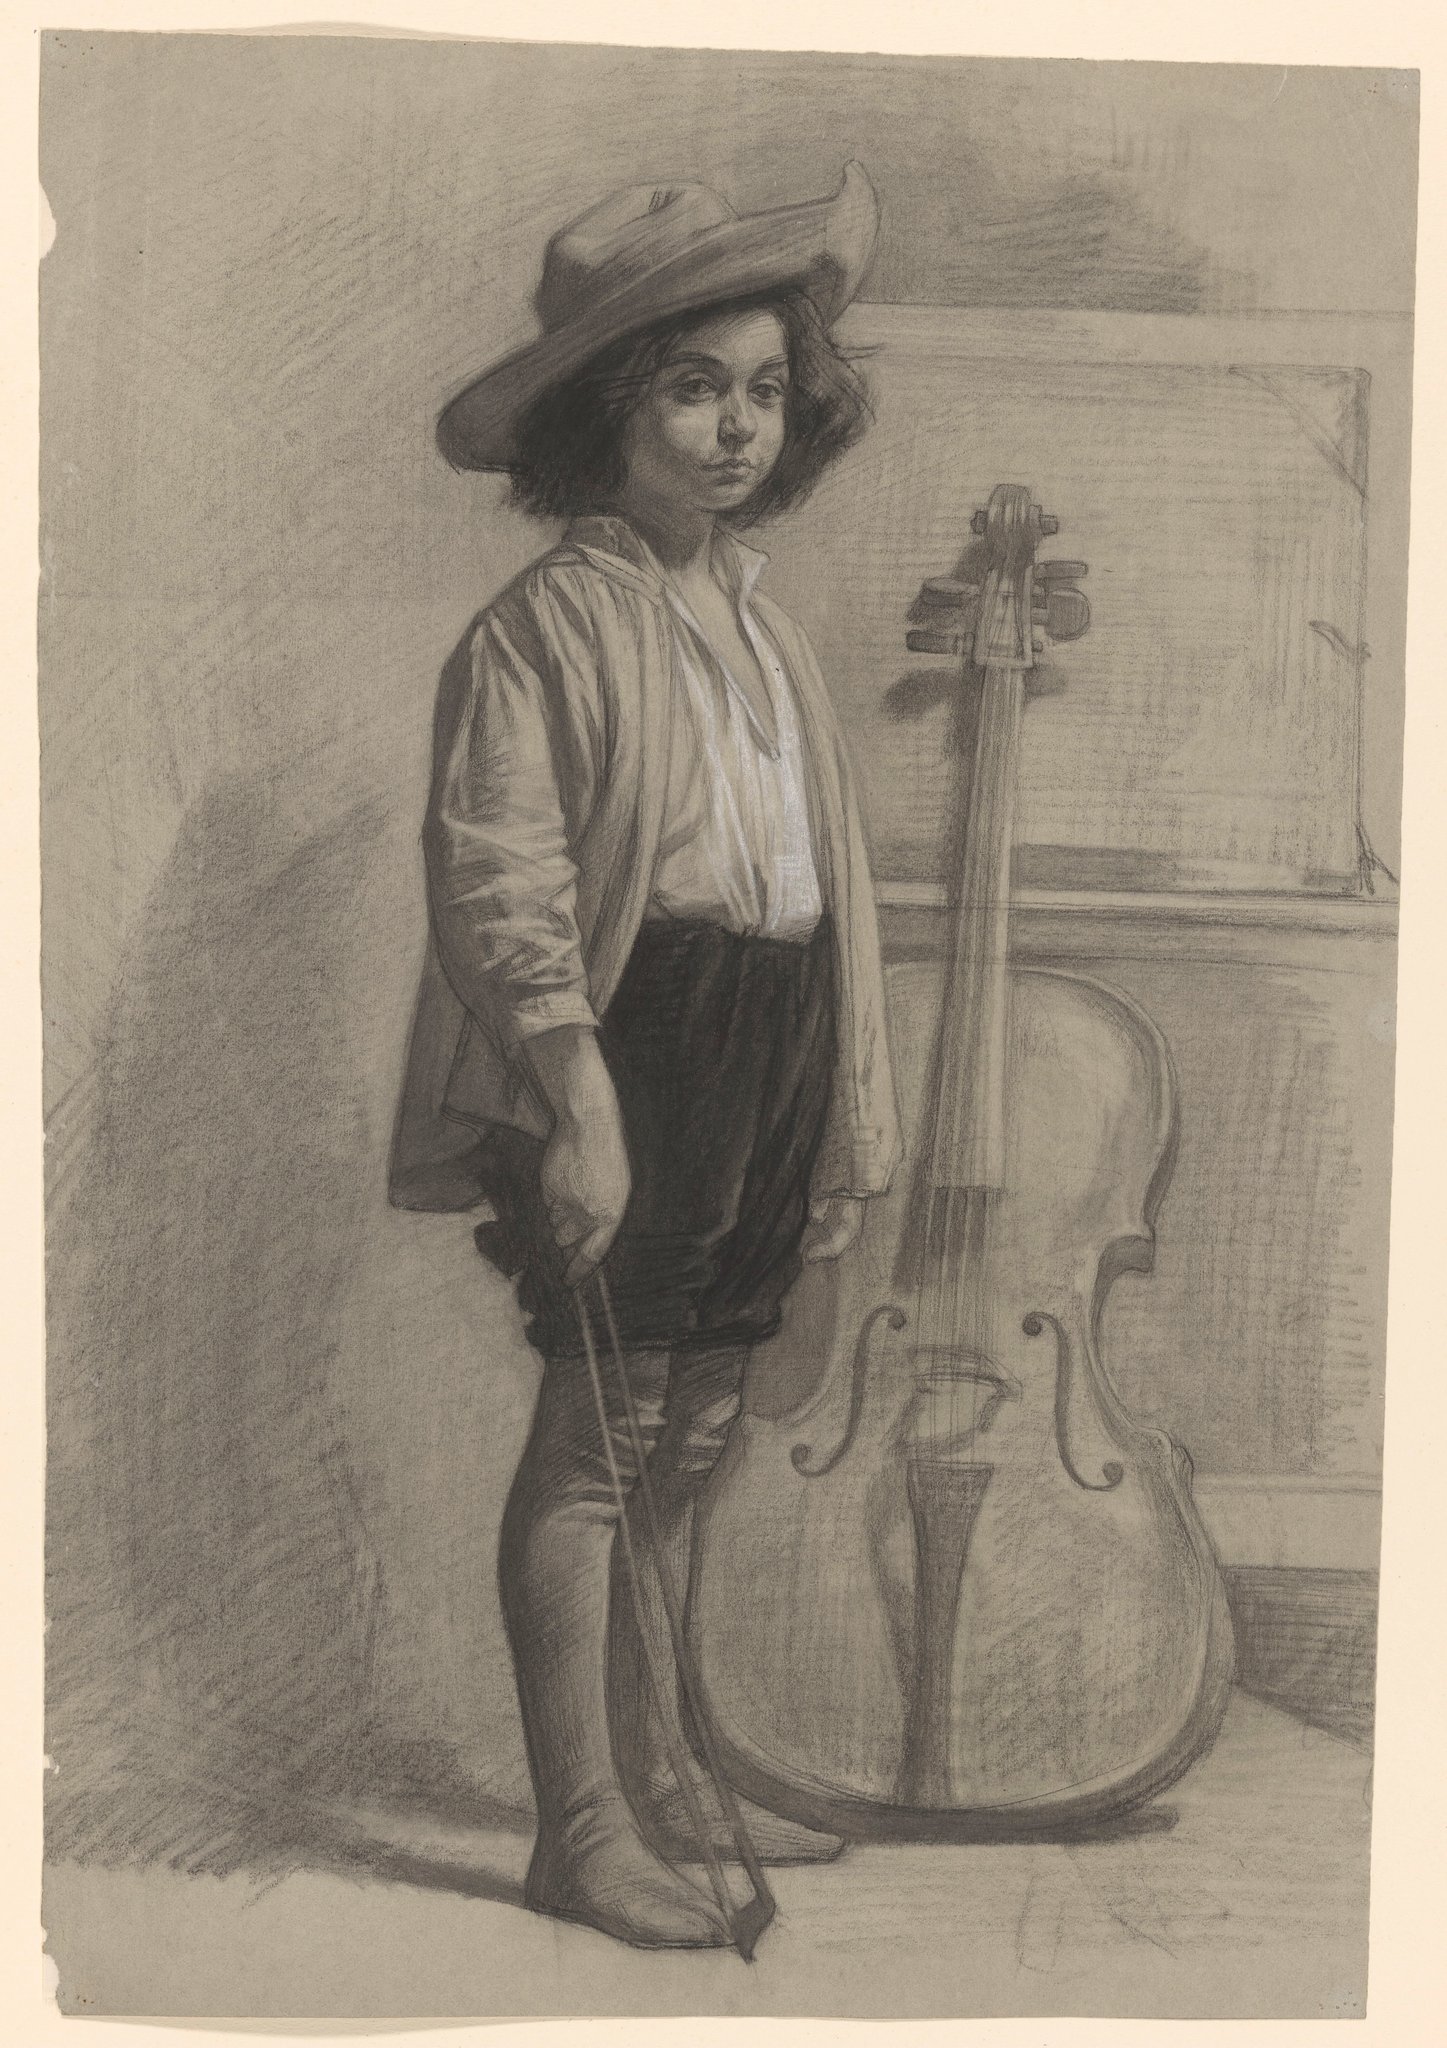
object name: drawing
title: Jongen staande bij een cello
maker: jan veth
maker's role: designer, draughtsman, painter, print maker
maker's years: 1864-1925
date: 1874-1925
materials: chalk, paper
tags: viola, violoncello; double bass